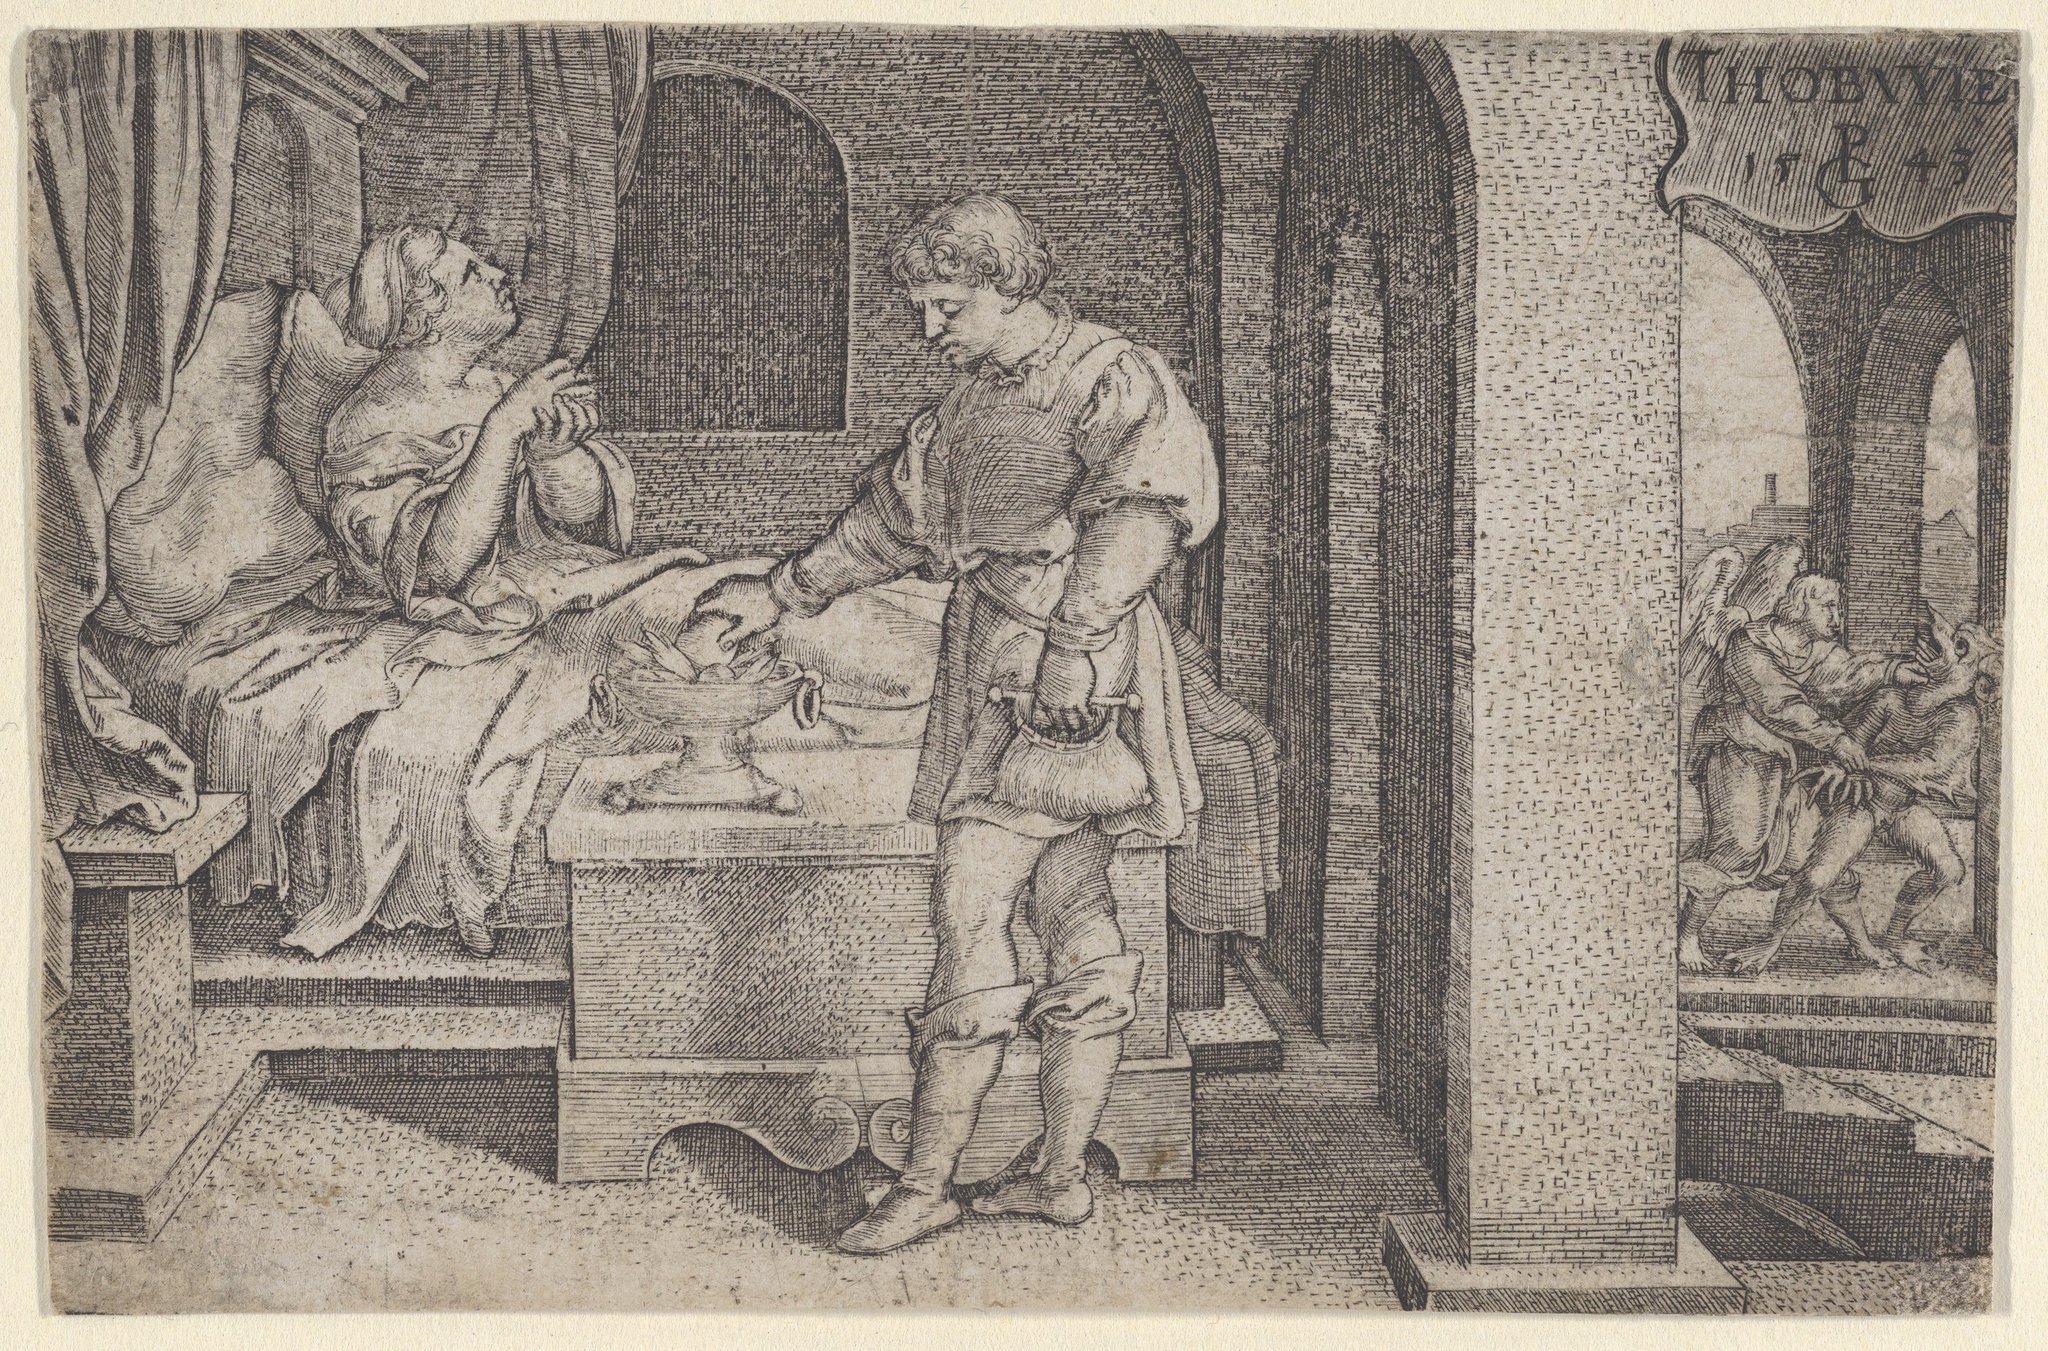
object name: print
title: Tobiolus Makes a Propitiatory Sacrifice, from "The Story of Tobias"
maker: georg pencz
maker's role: artist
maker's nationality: german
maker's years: 1500-1550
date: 1543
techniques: engraving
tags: fruit,men,beds